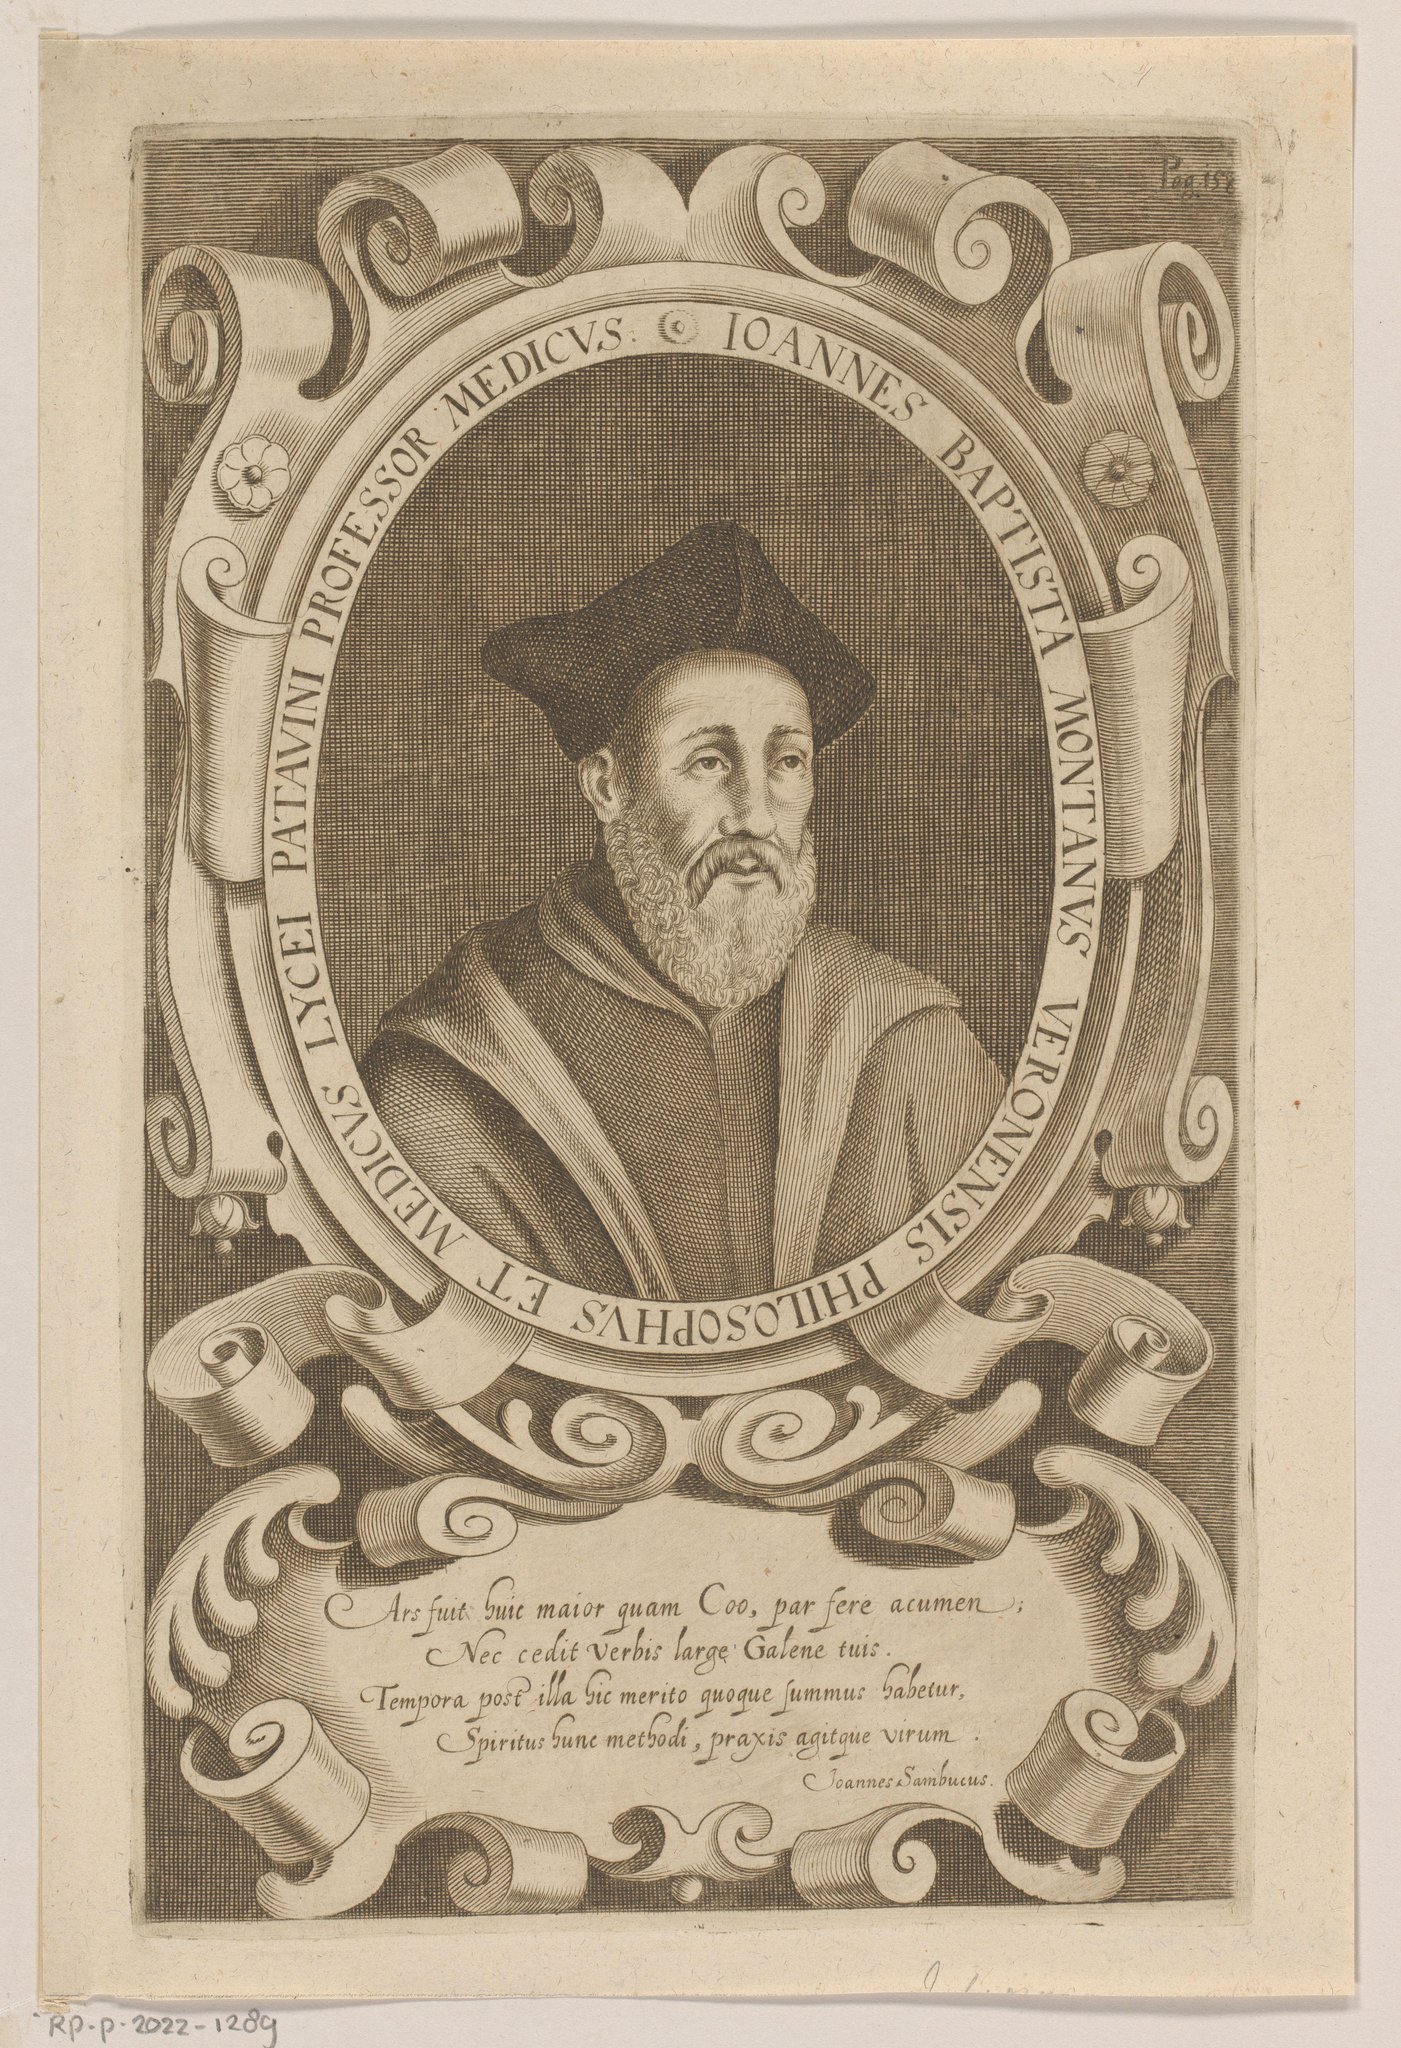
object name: print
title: Portret van Johannes Baptista Montanus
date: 1550-1650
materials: paper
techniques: engraving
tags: historical persons, physician, doctor (+ portrait of scholar, scientist)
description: Met vierregelig onderschrift in het Latijn. Rechtsboven: Pag. 158.